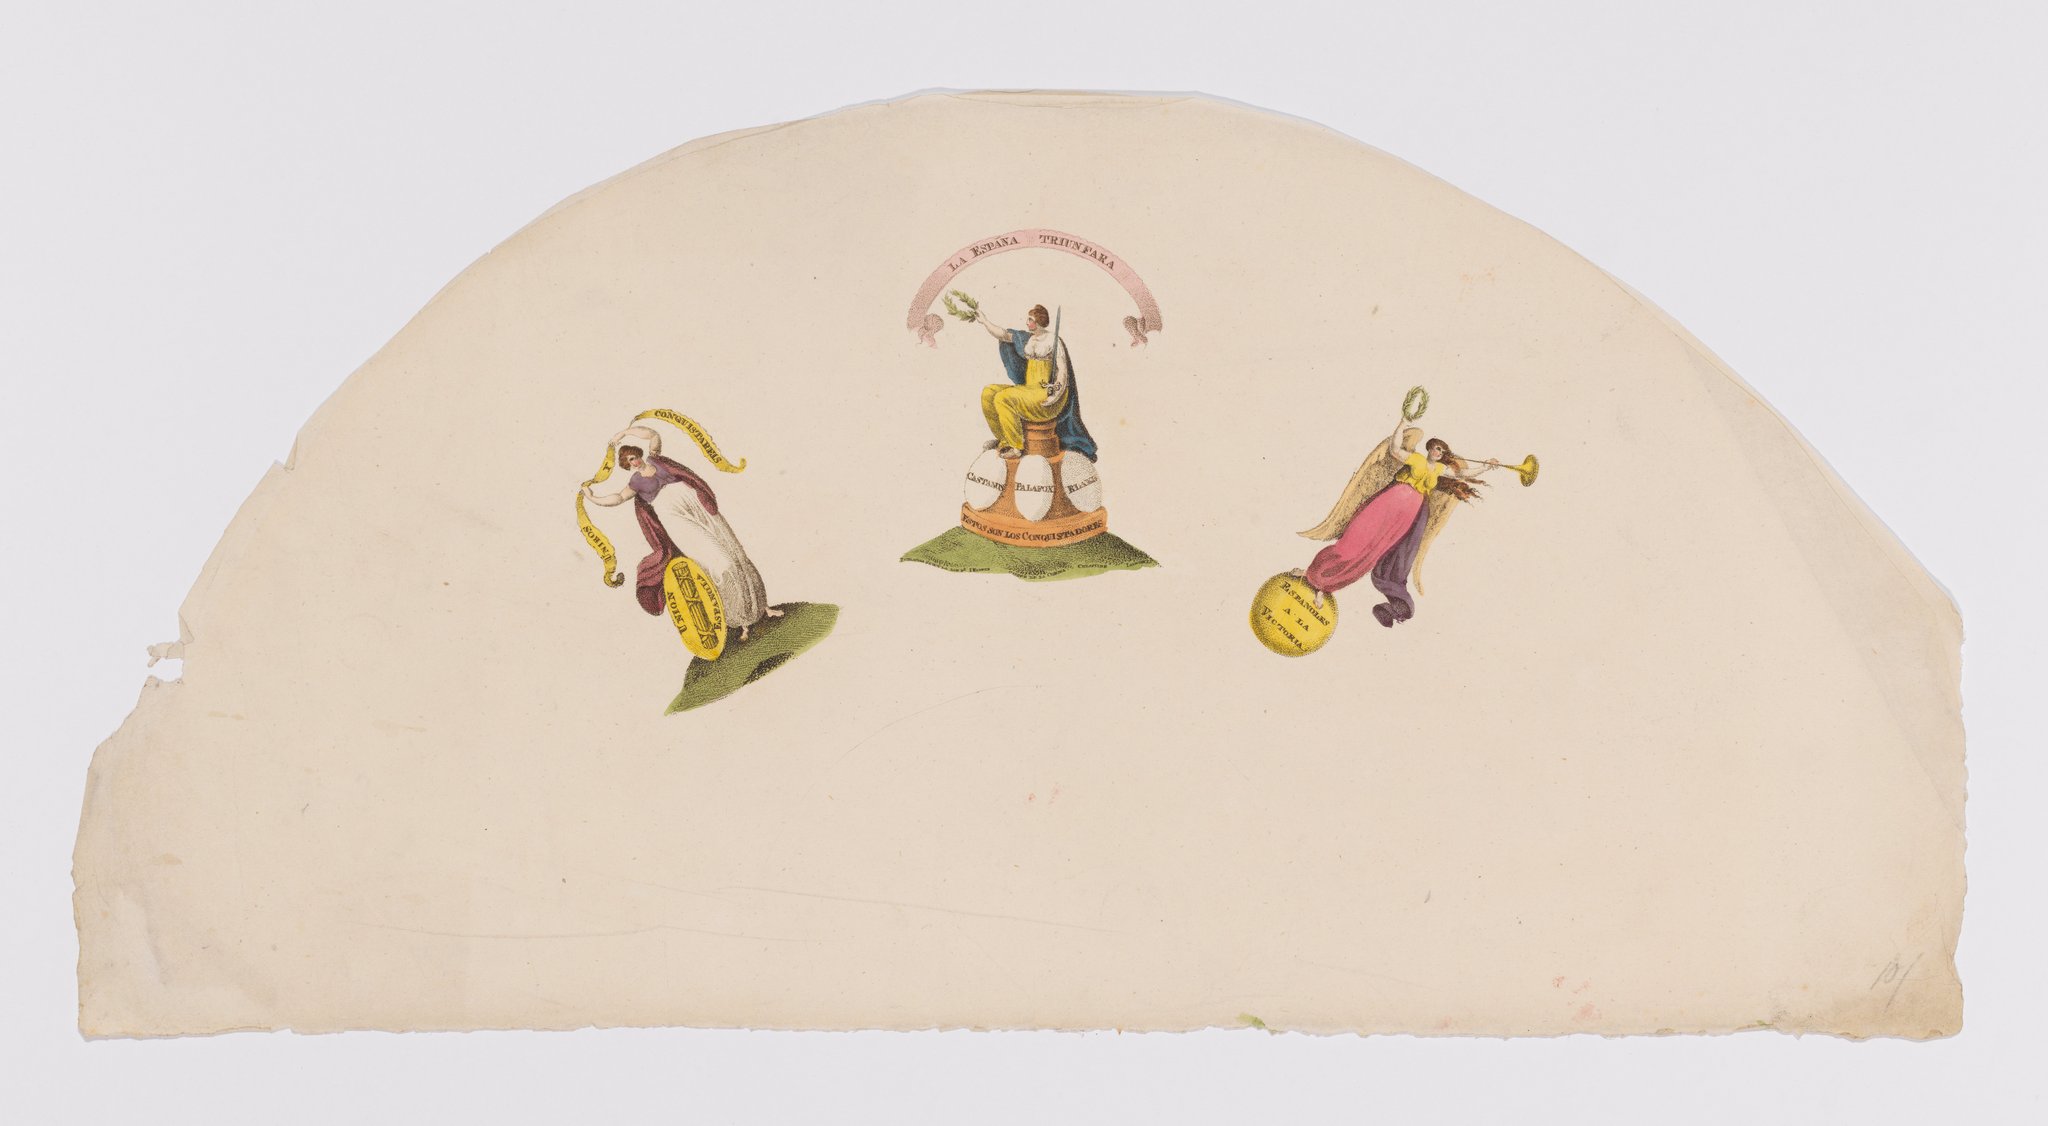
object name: print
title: La España Triunfara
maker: anonymous, british, 19th century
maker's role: artist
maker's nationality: british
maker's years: 1800-1900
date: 1814-1815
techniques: hand coloring, engraving